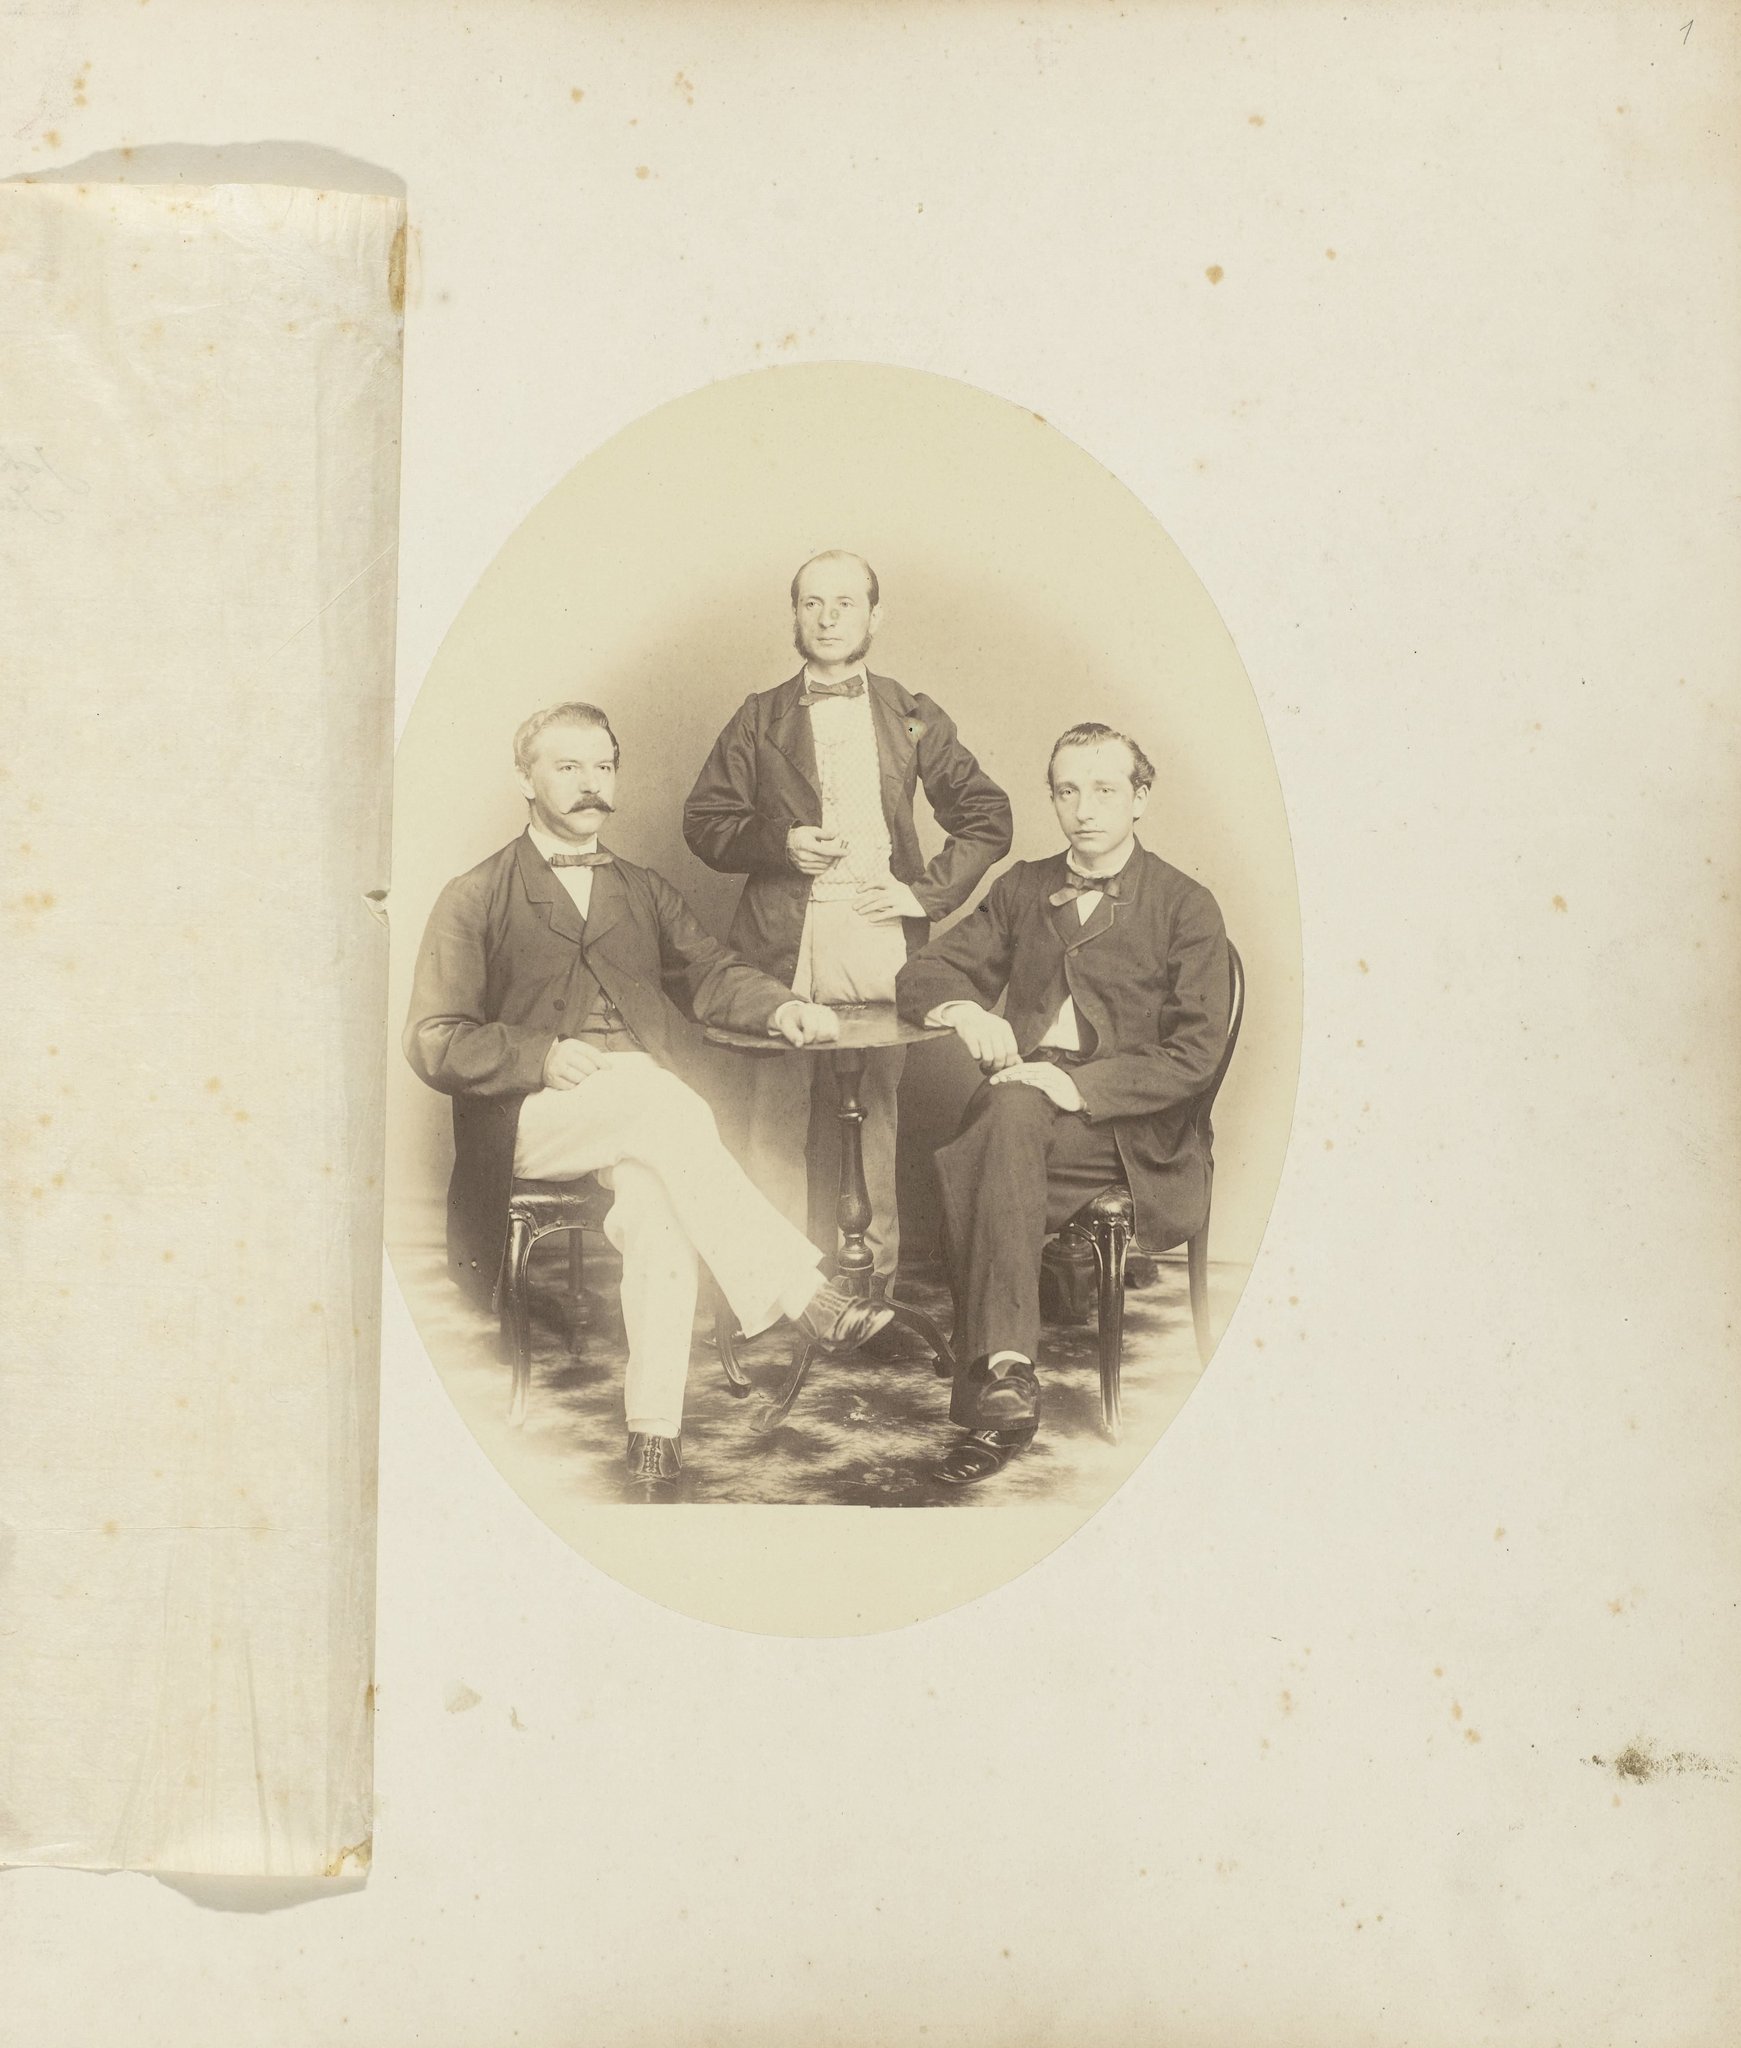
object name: photograph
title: Portret van drie Europese mannen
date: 1863-1866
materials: photographic support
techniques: albumen print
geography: batavia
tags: historical persons, java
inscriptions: inscription: ‘John / Jan / Vice’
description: Portret van drie Europese mannnen, zittend en staand poserend rond een tafeltje. Mogelijk betreft het degenen die het album hebben geschonken. Onderdeel van het rode fotoalbum met foto's van Java, uit het bezit van apotheker Specht-Grijp, die in 1865 vanuit Batavia naar Nederland terugkeerde.